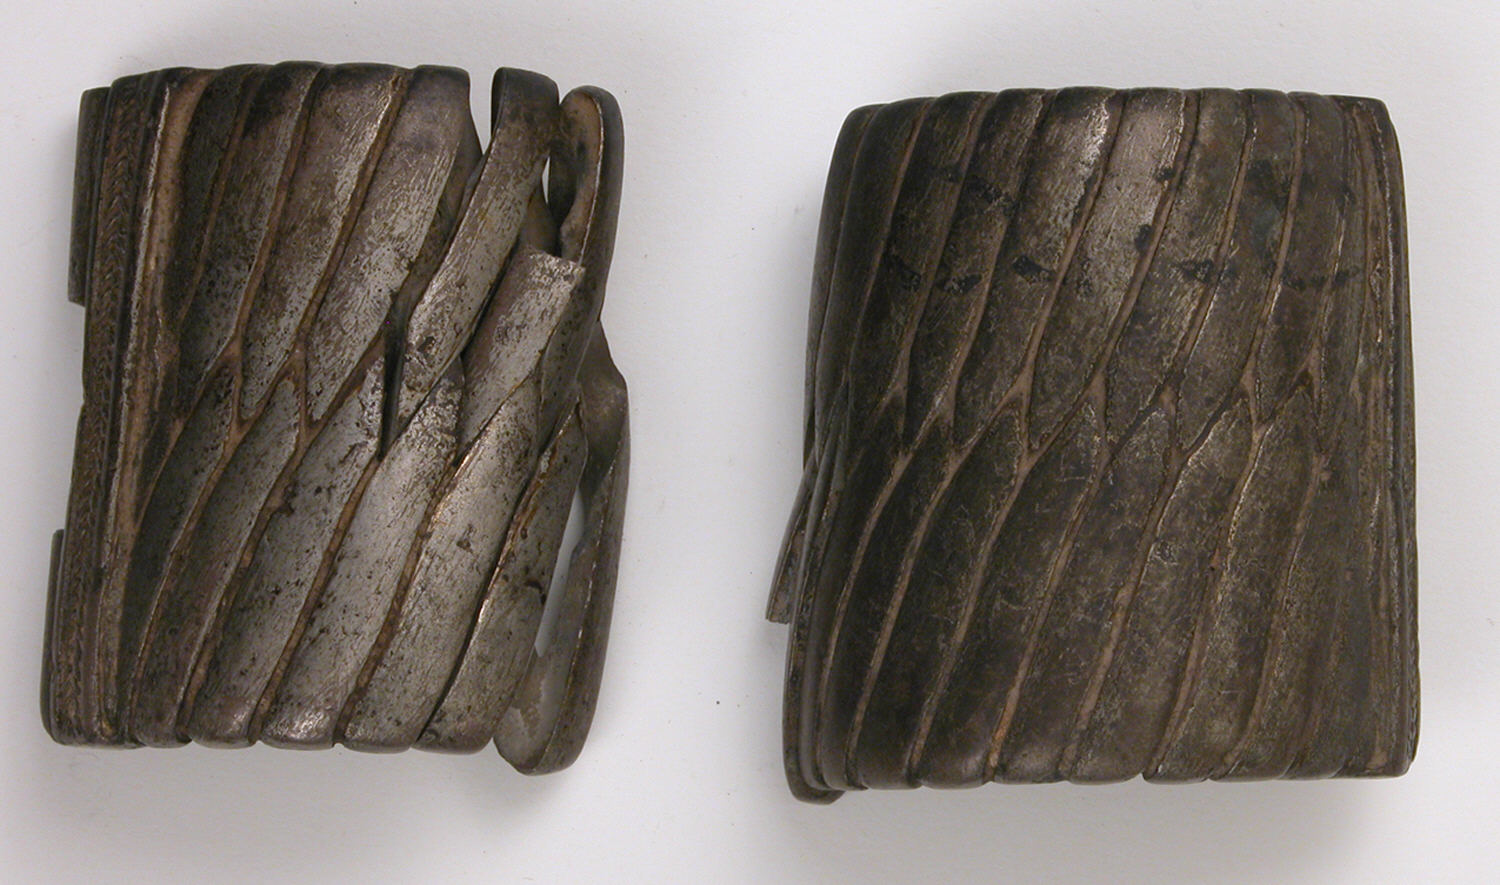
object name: anklet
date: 1801-1900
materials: metal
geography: central india